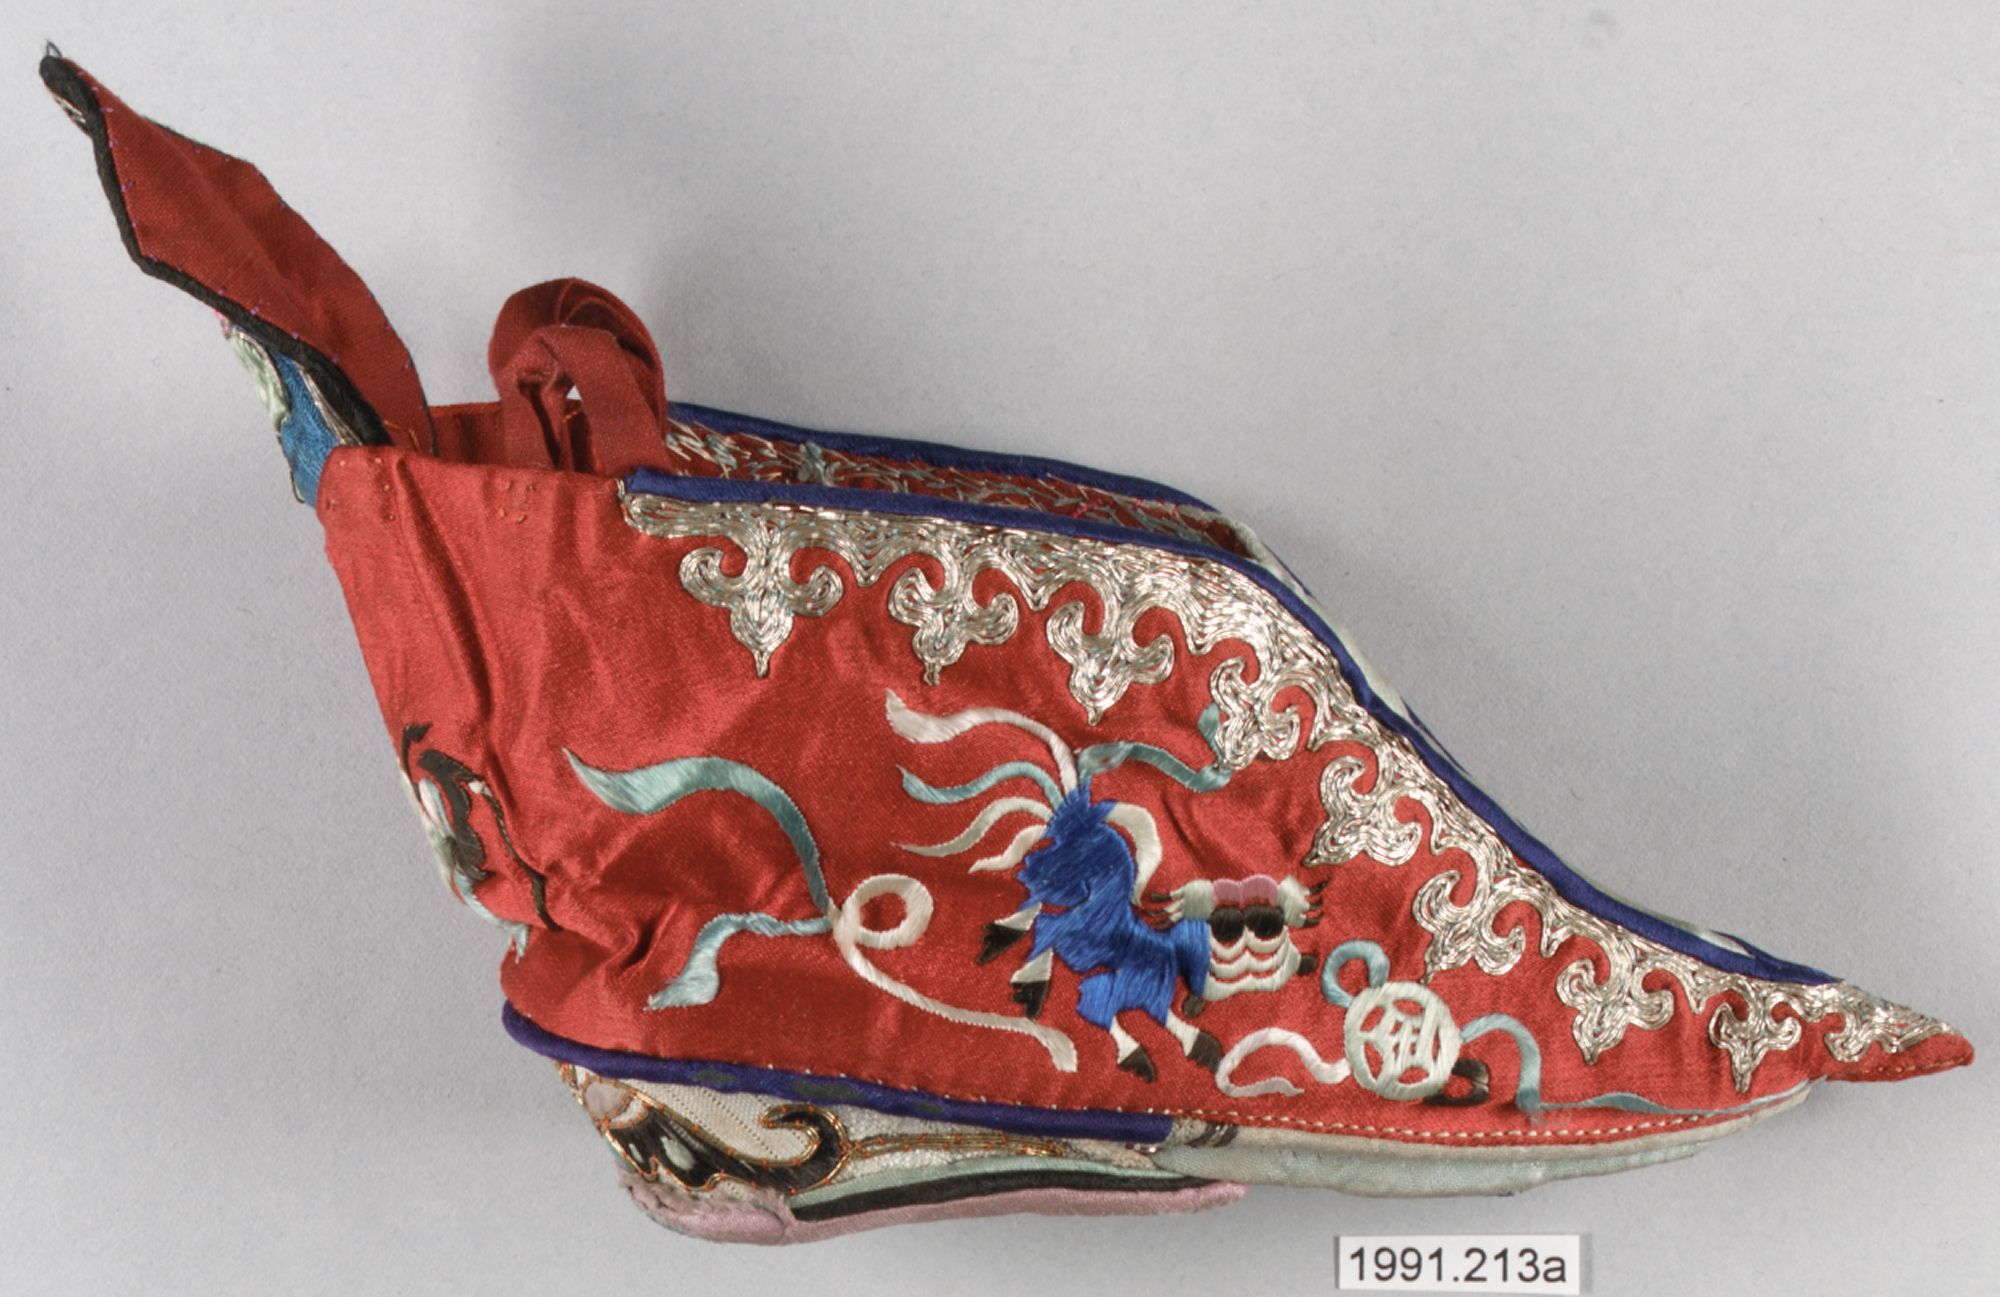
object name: slipper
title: Slippers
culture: chinese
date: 1867-1900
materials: metal thread, silk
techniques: embroidery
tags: animals